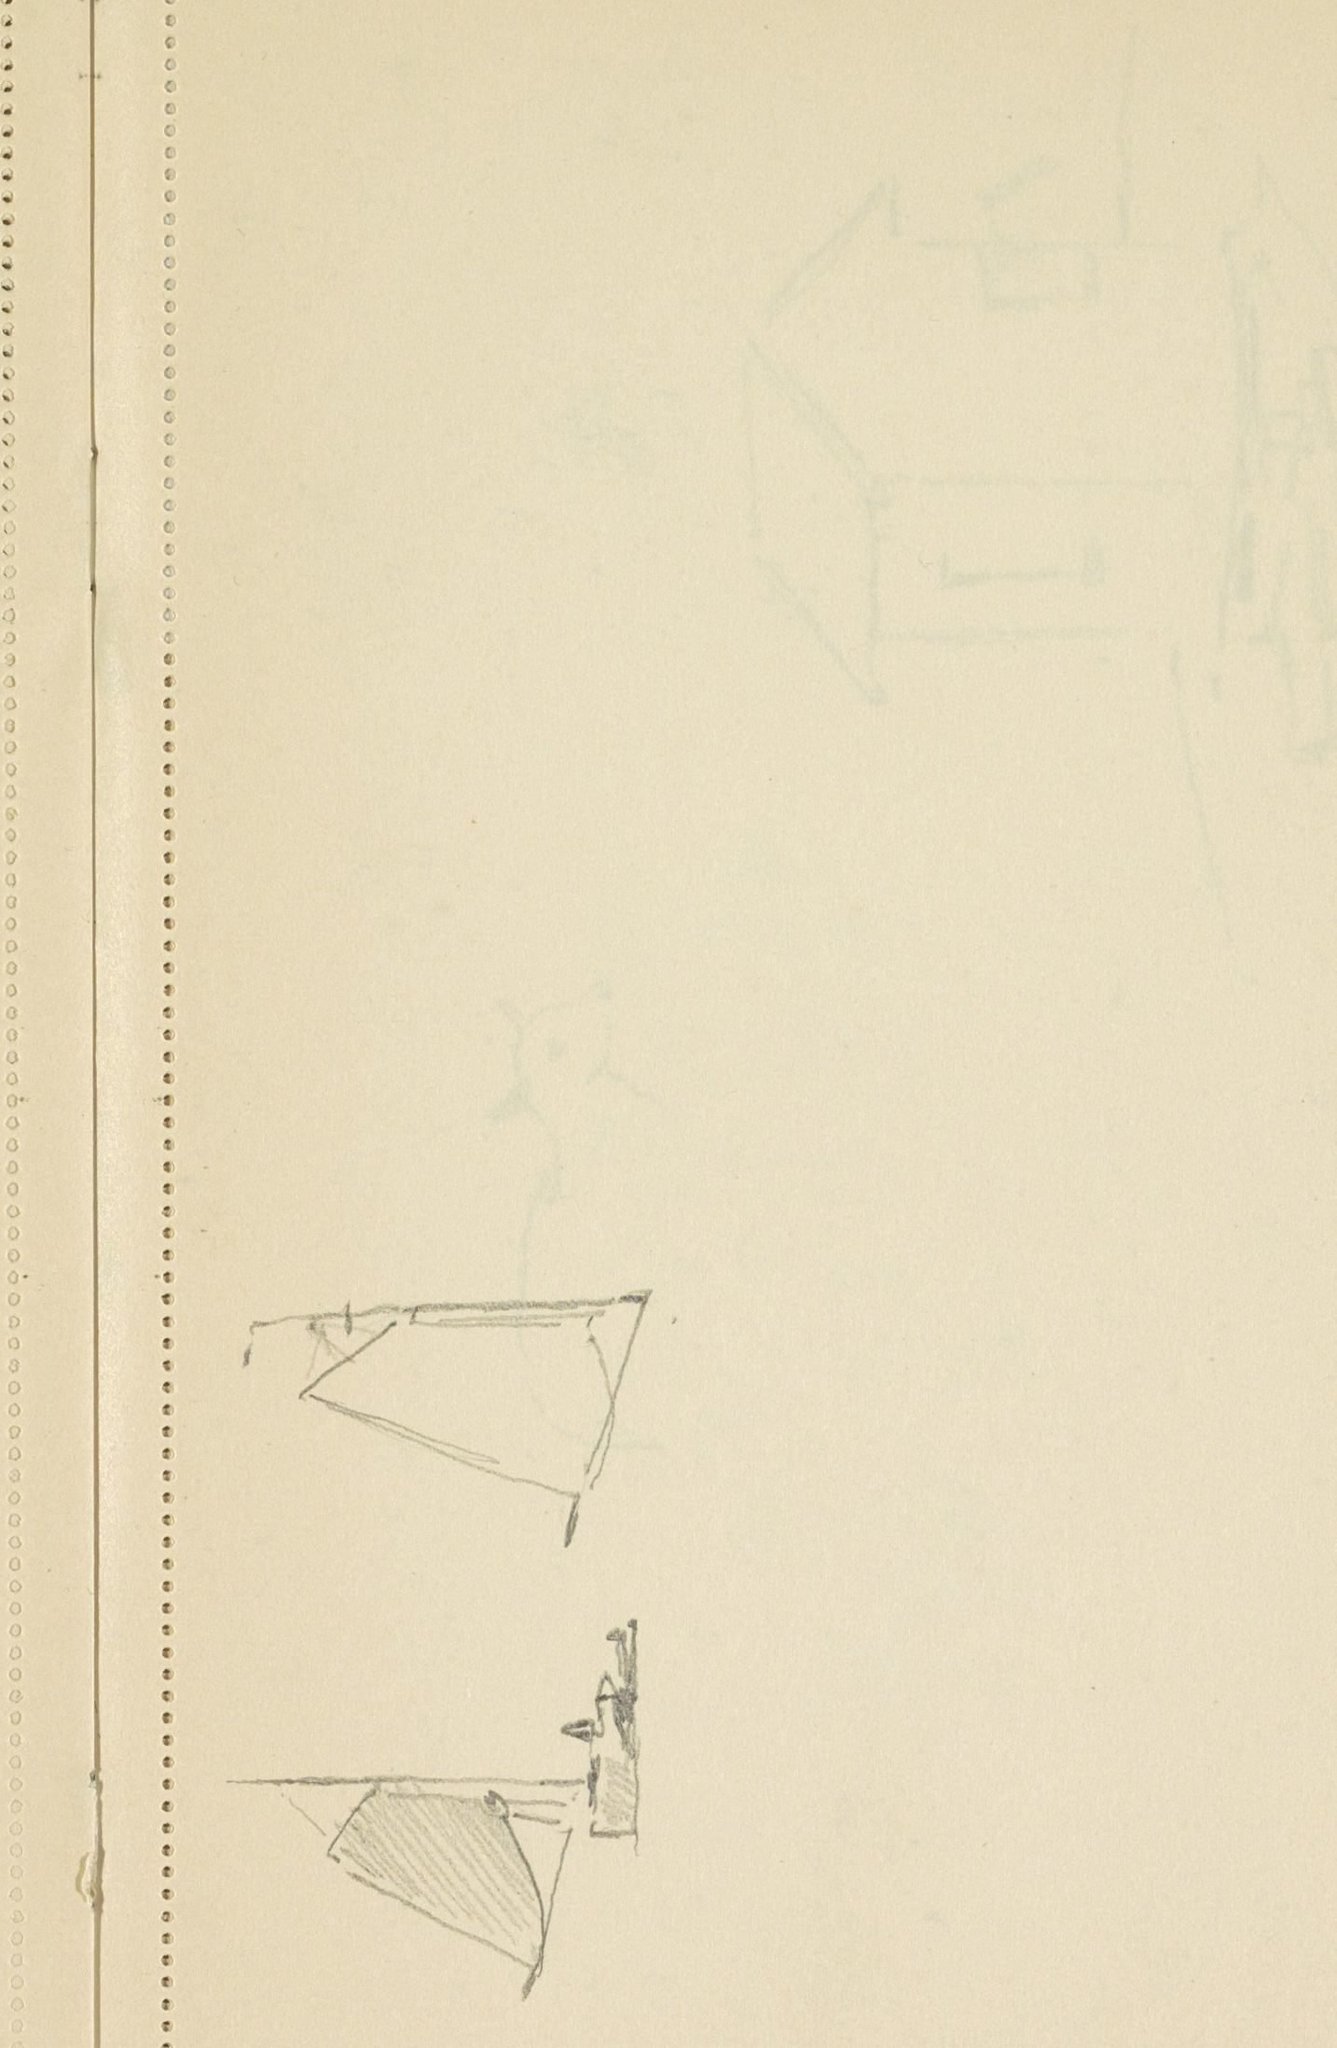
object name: sketchbook leaf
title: Zeilschip en een zeil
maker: cornelis vreedenburgh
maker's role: draughtsman, print maker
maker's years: 1880-1946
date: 1890-1946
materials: paper, pencil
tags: sail, sailing-ship, sailing-boat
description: Blad 28 recto uit een schetsboek met 73 bladen.